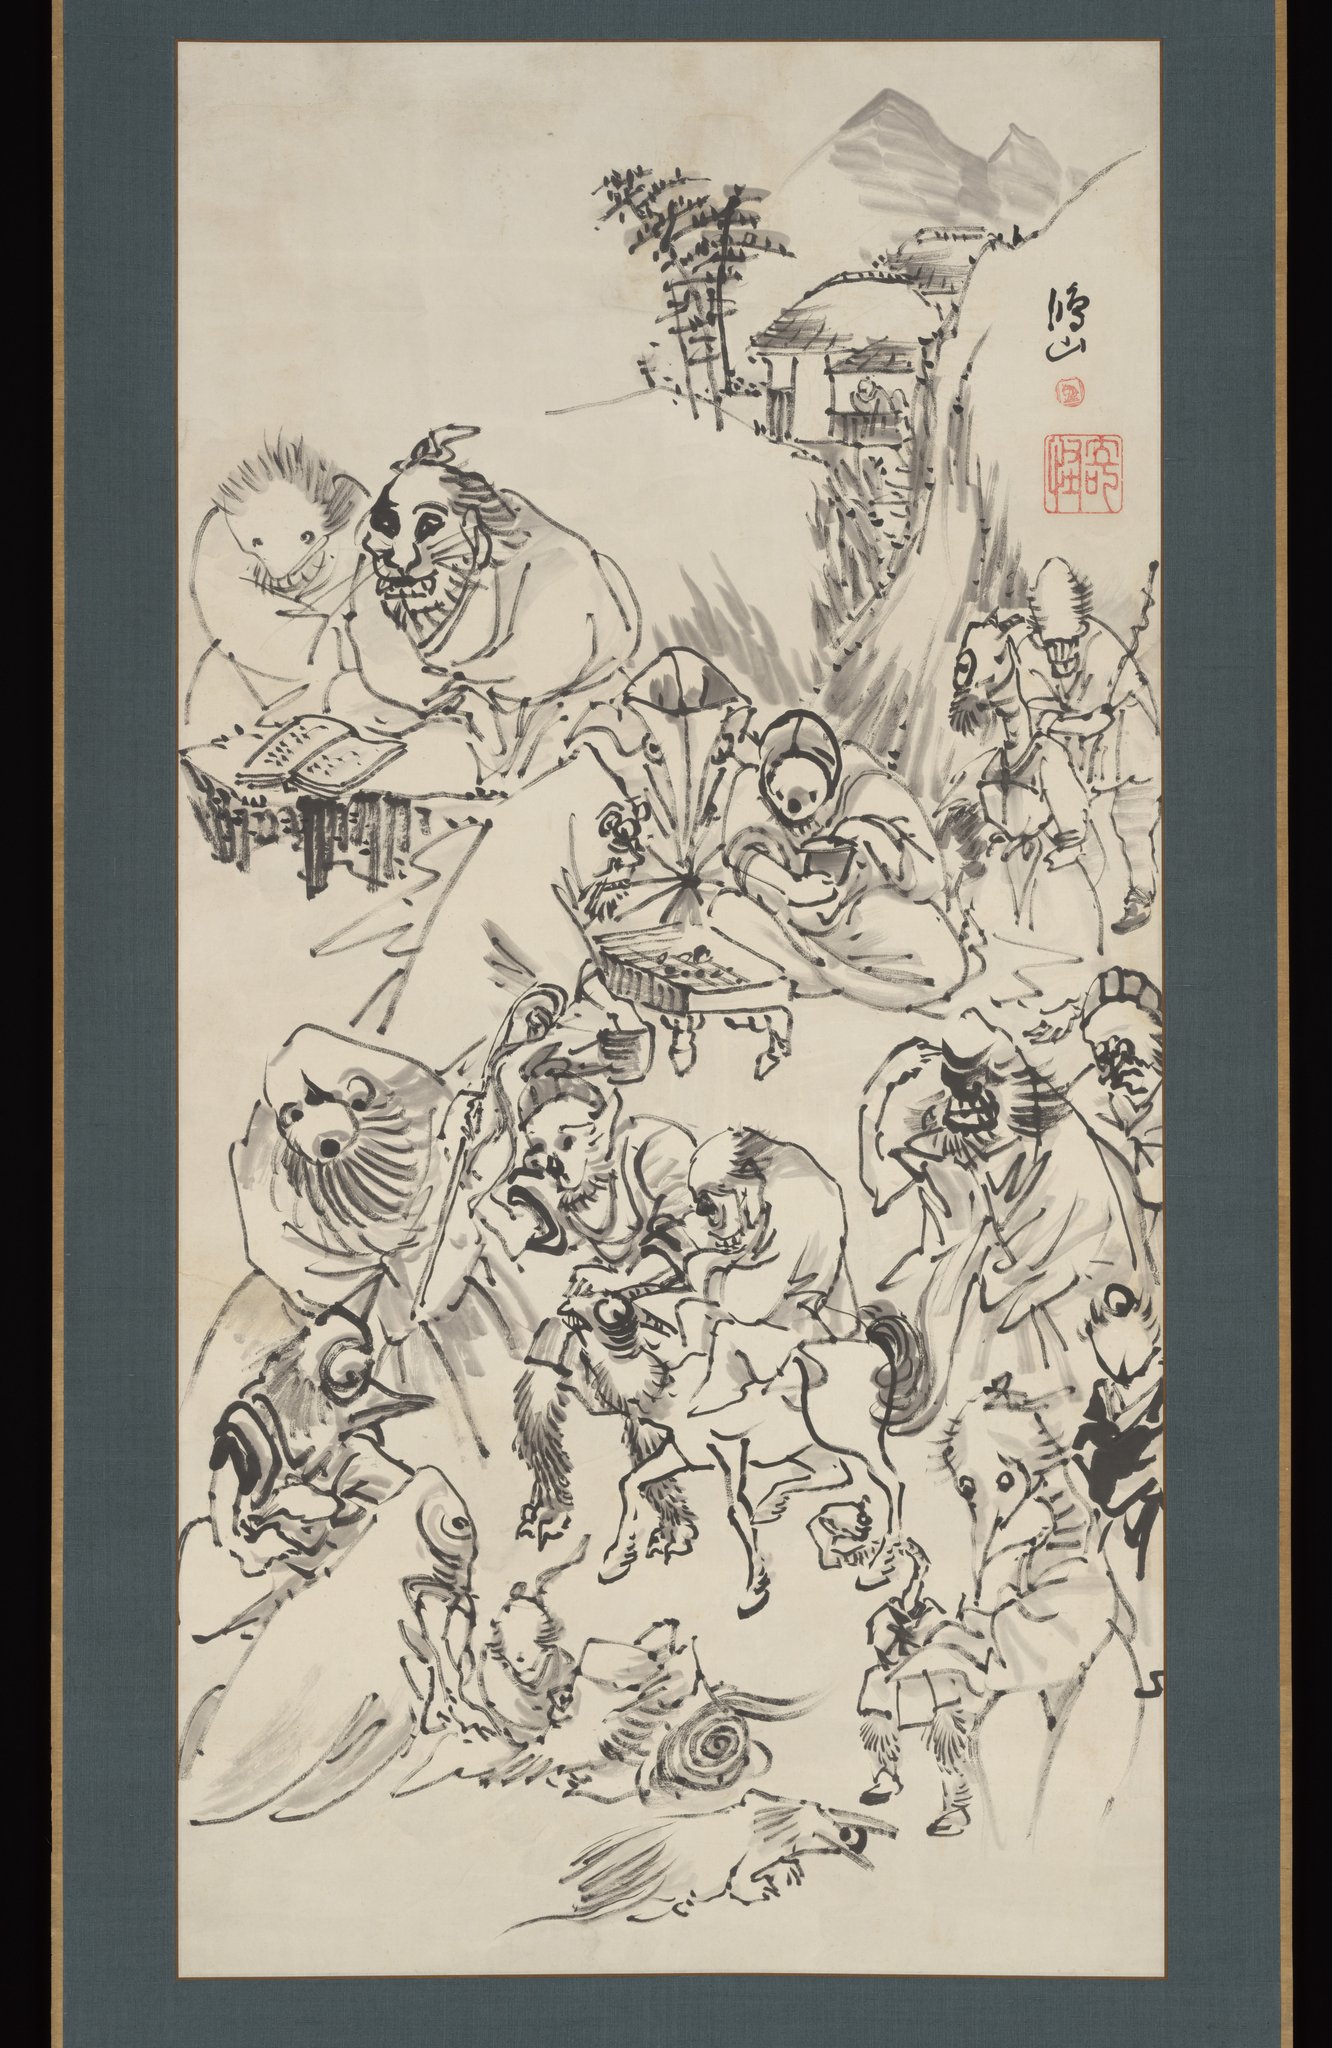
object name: hanging scroll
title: Demons and Monsters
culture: japanese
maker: takai kōzan 高井鴻山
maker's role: artist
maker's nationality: japanese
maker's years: 1806-1883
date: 1870-1879